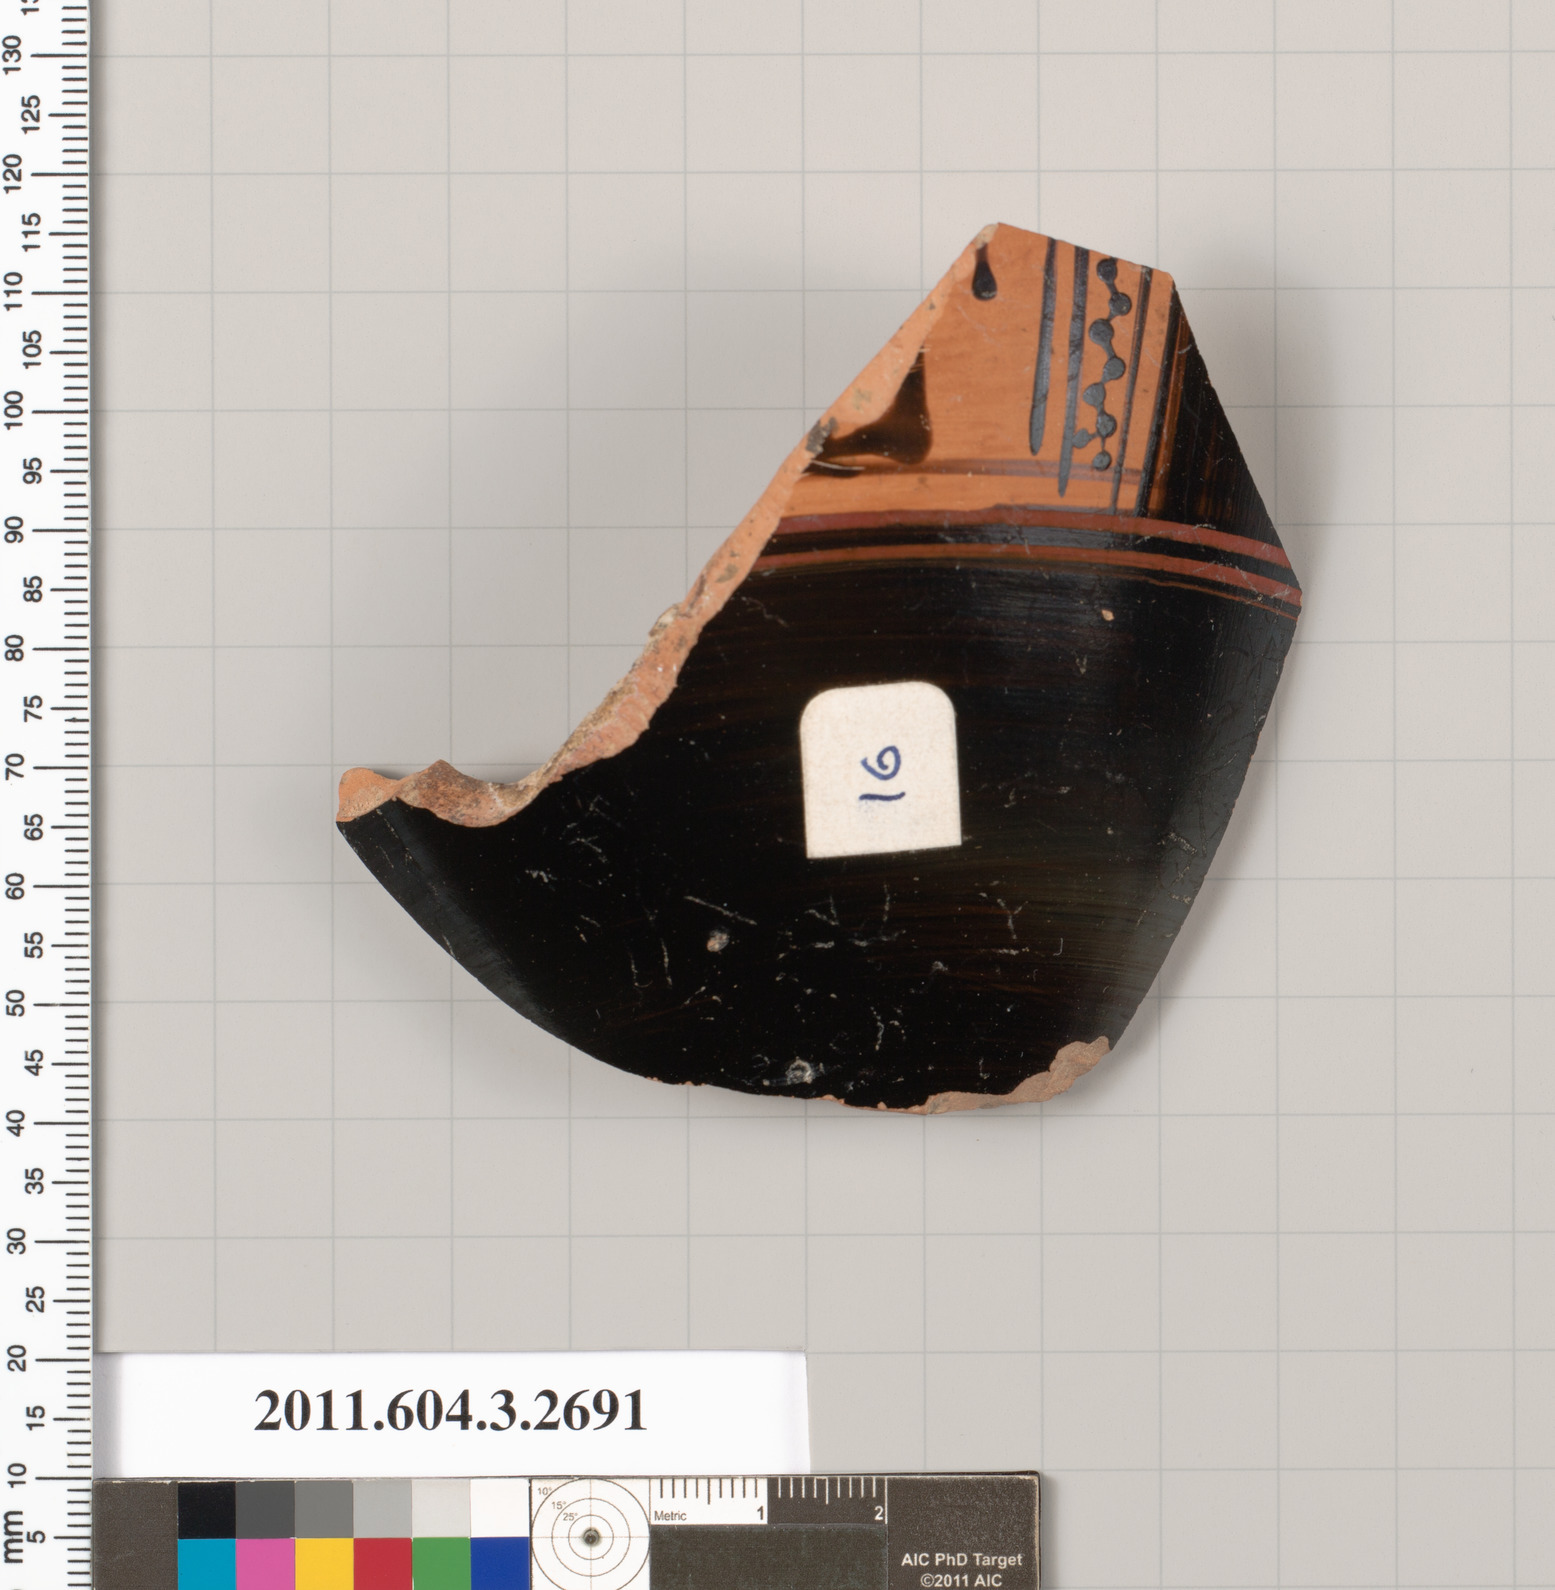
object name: oinochoe fragment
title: Terracotta fragment of an oinochoe (jug)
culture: greek, attic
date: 510-500 BCE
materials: terracotta